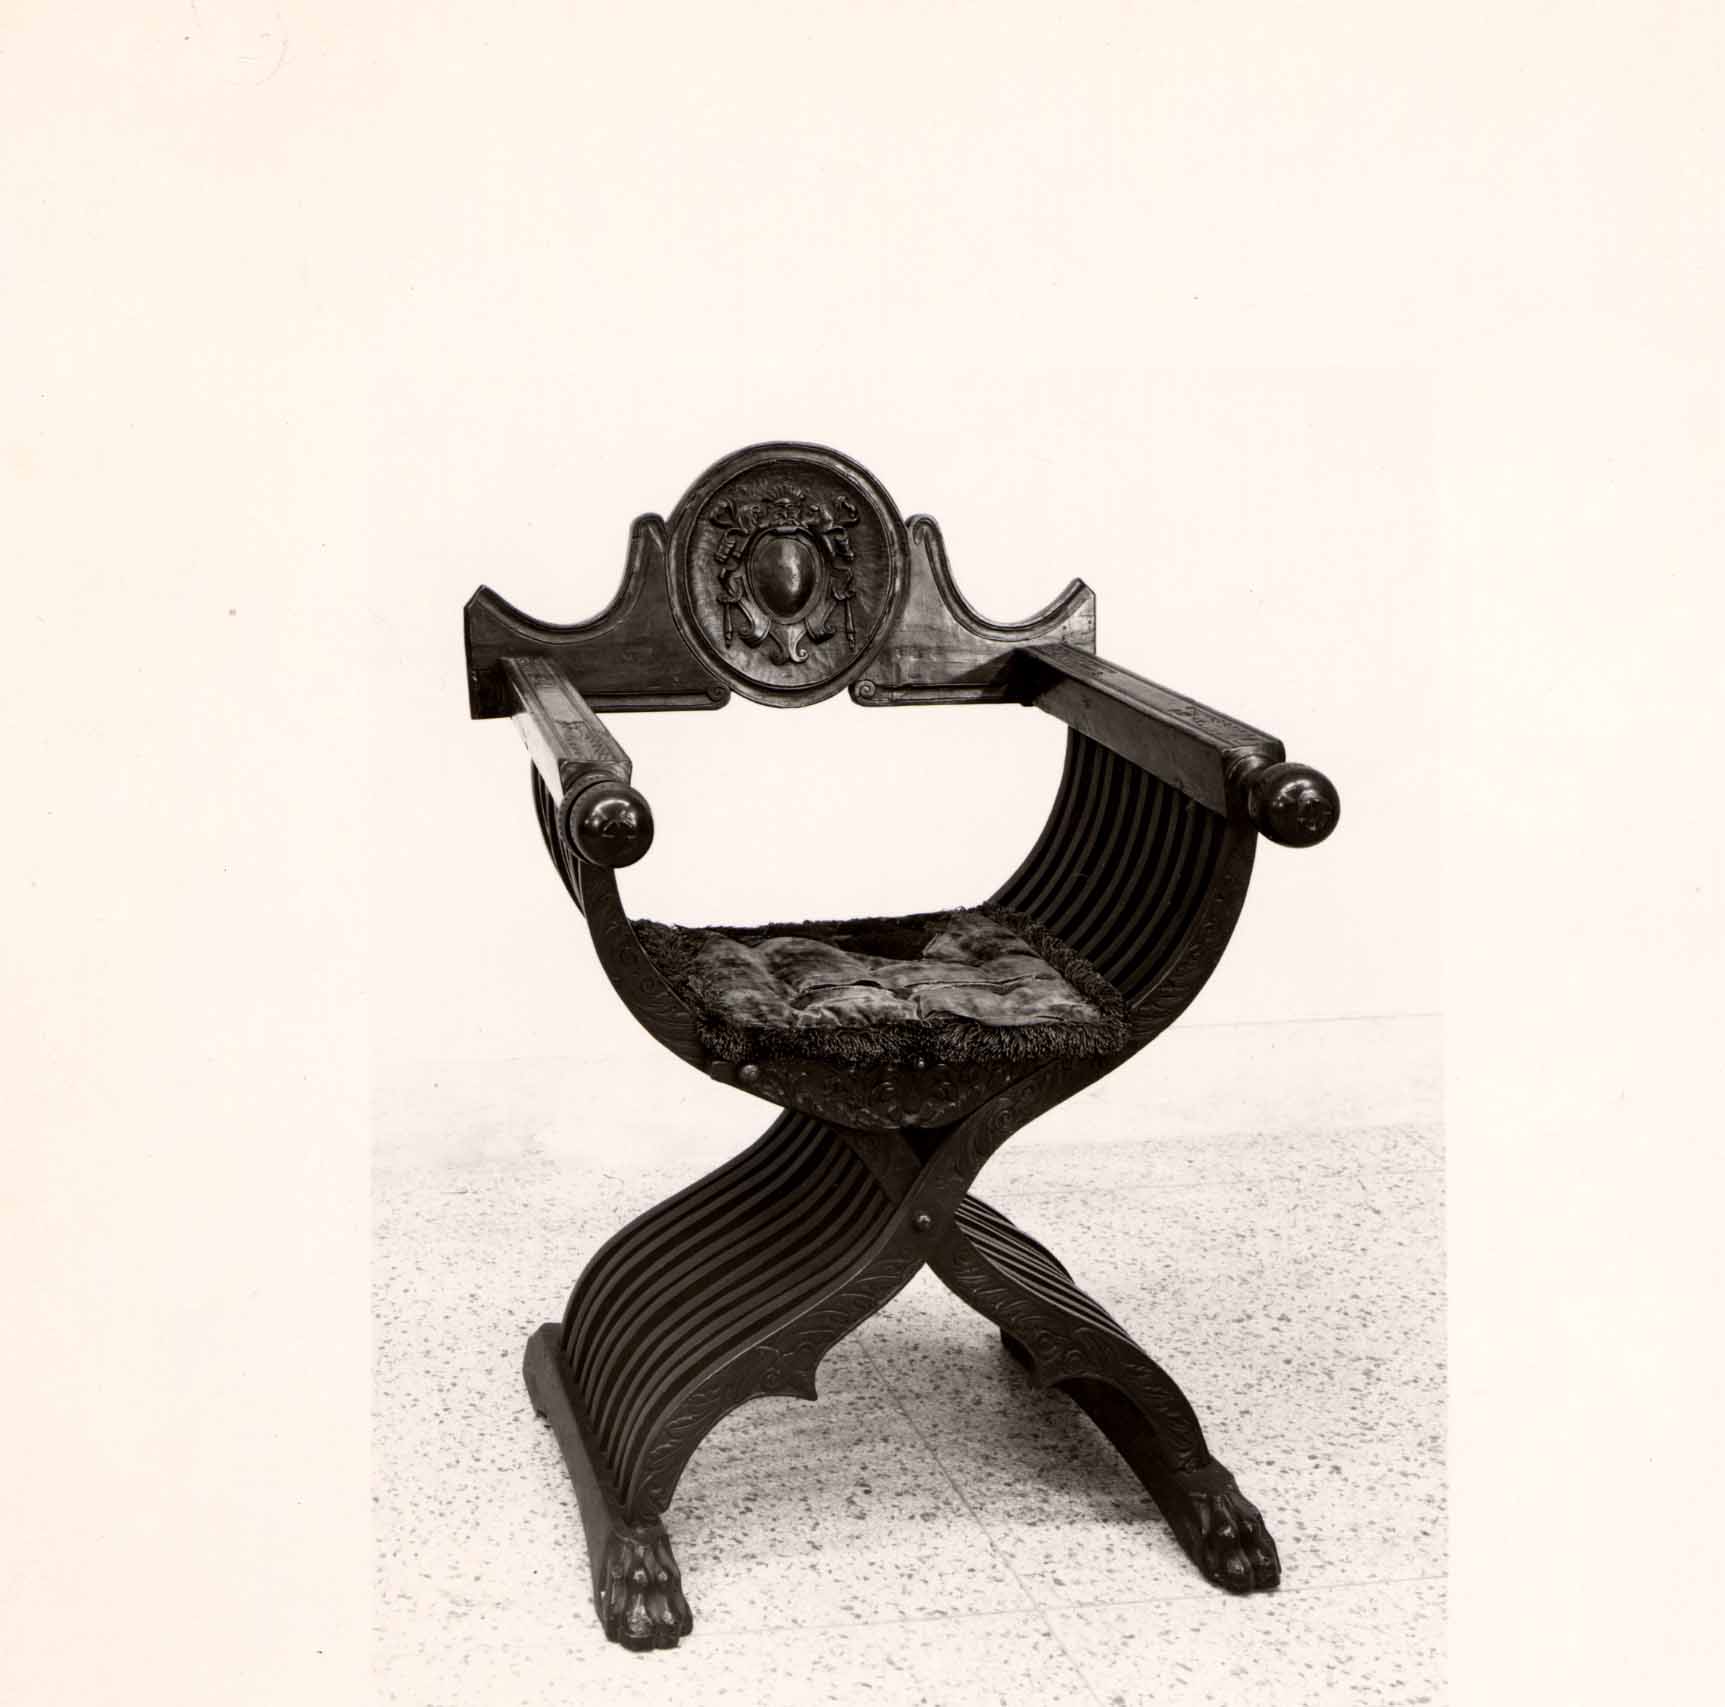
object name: armchair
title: Folding armchair (sedia a Savonarola type)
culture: italian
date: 1401-1500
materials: silk, wood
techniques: carving